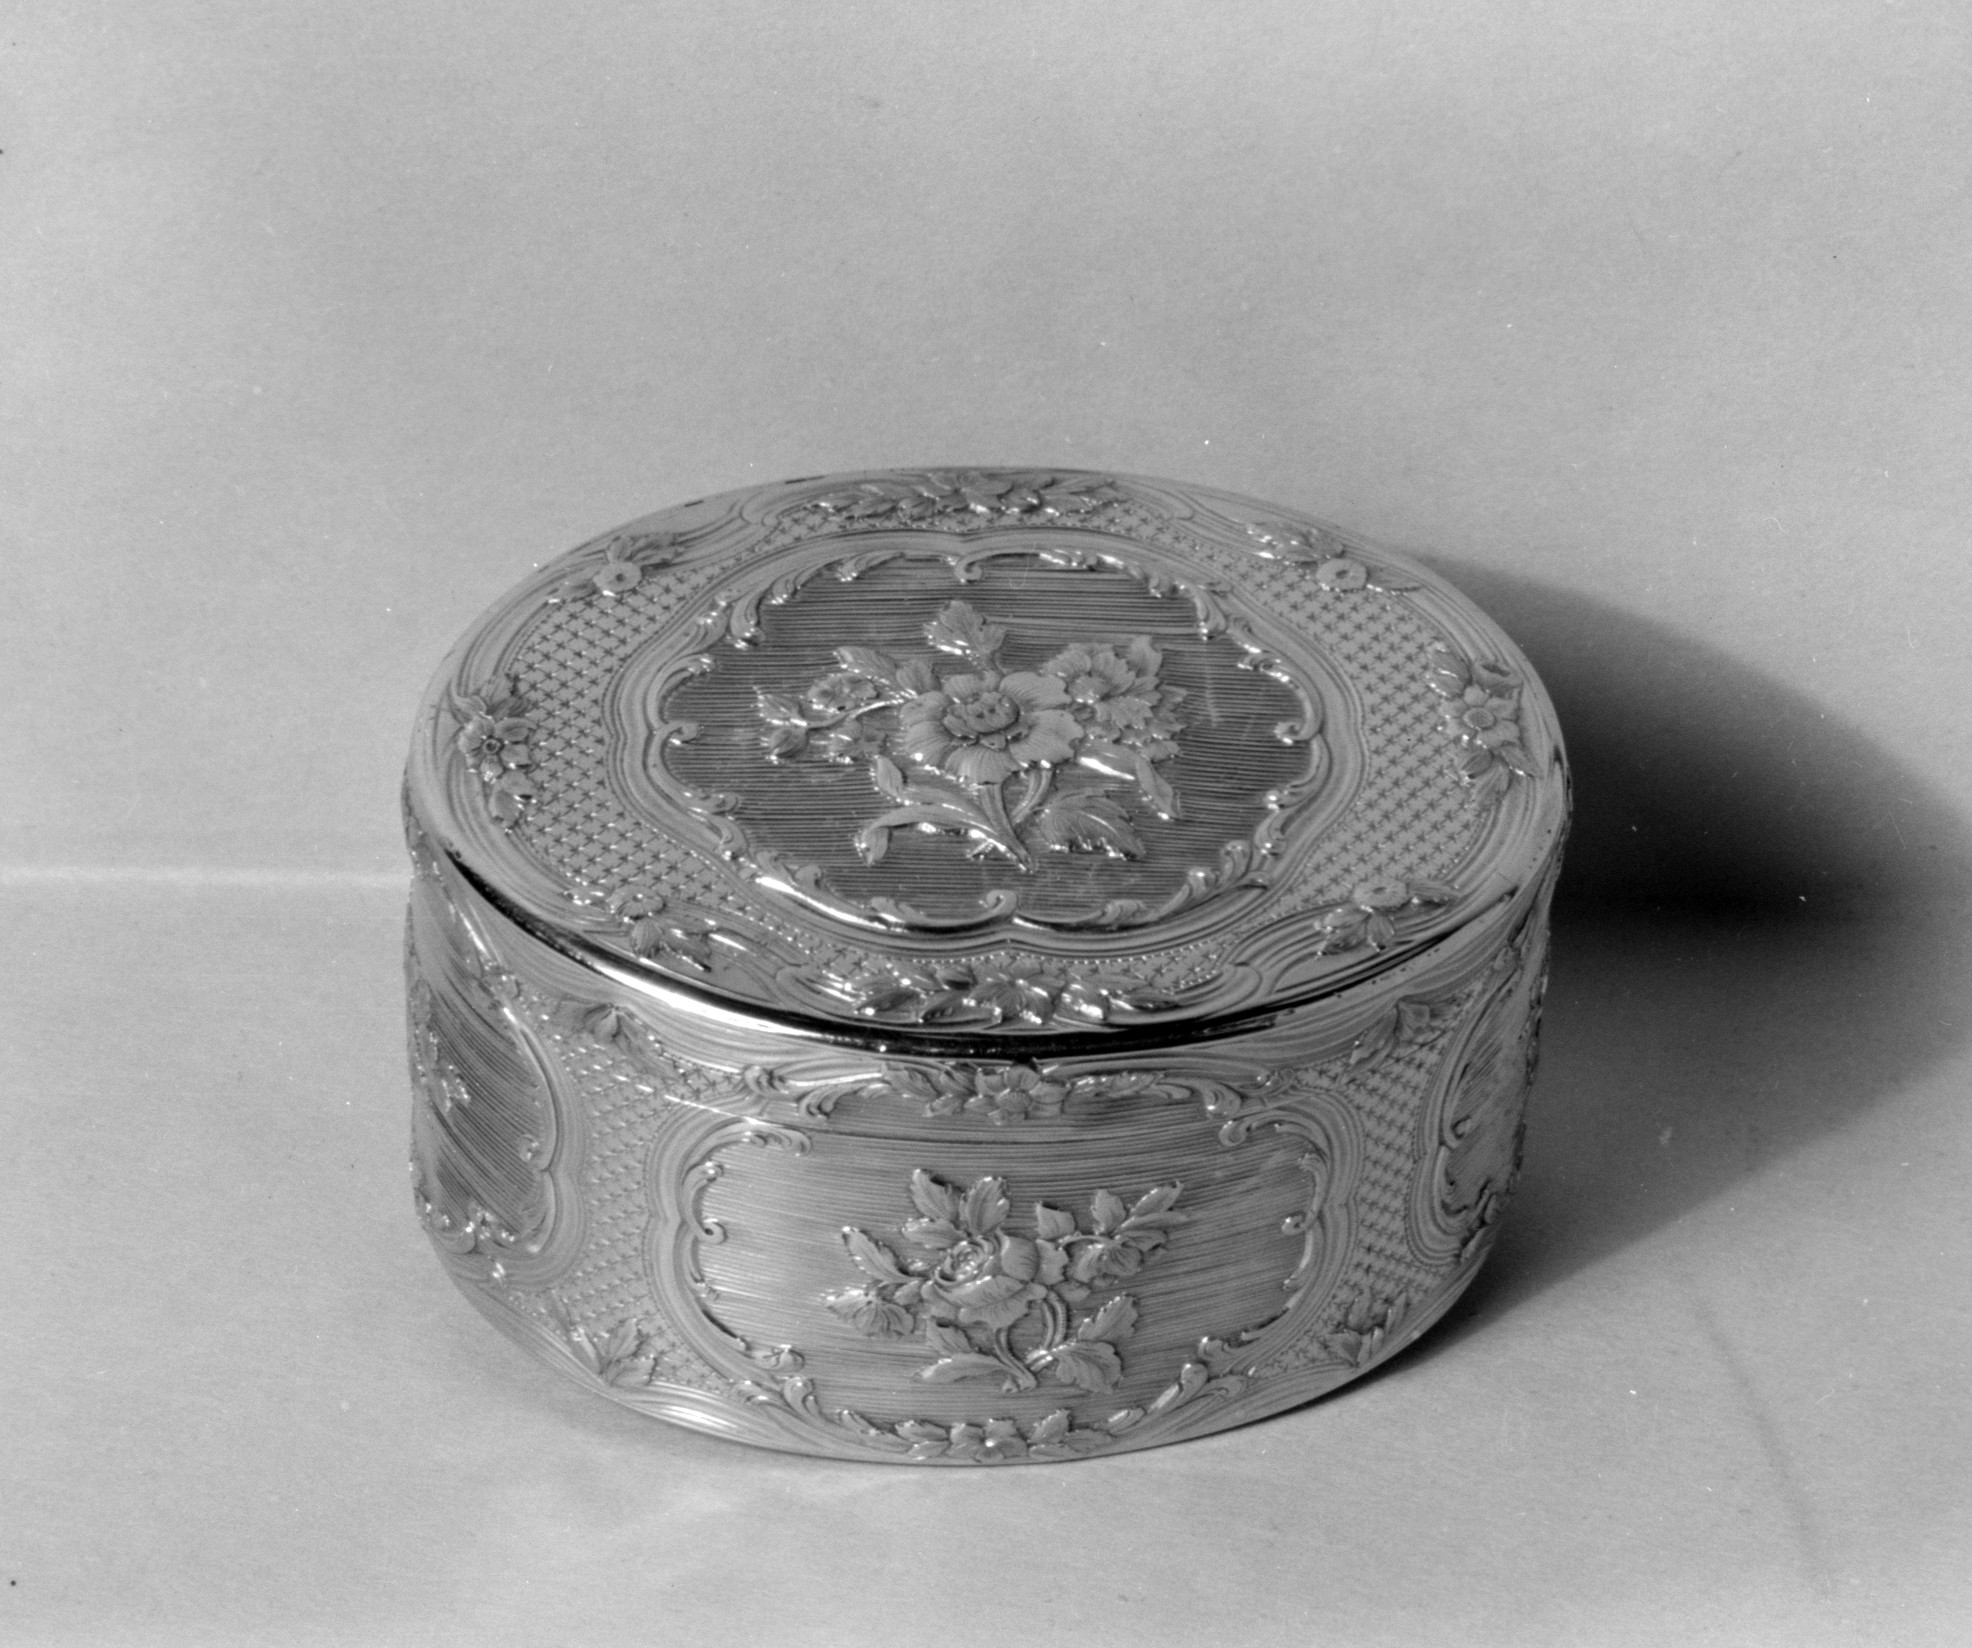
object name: snuffbox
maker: jean-charles-simphorien dubos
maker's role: maker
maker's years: 1719-1819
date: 1760-1761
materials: gold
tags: flowers